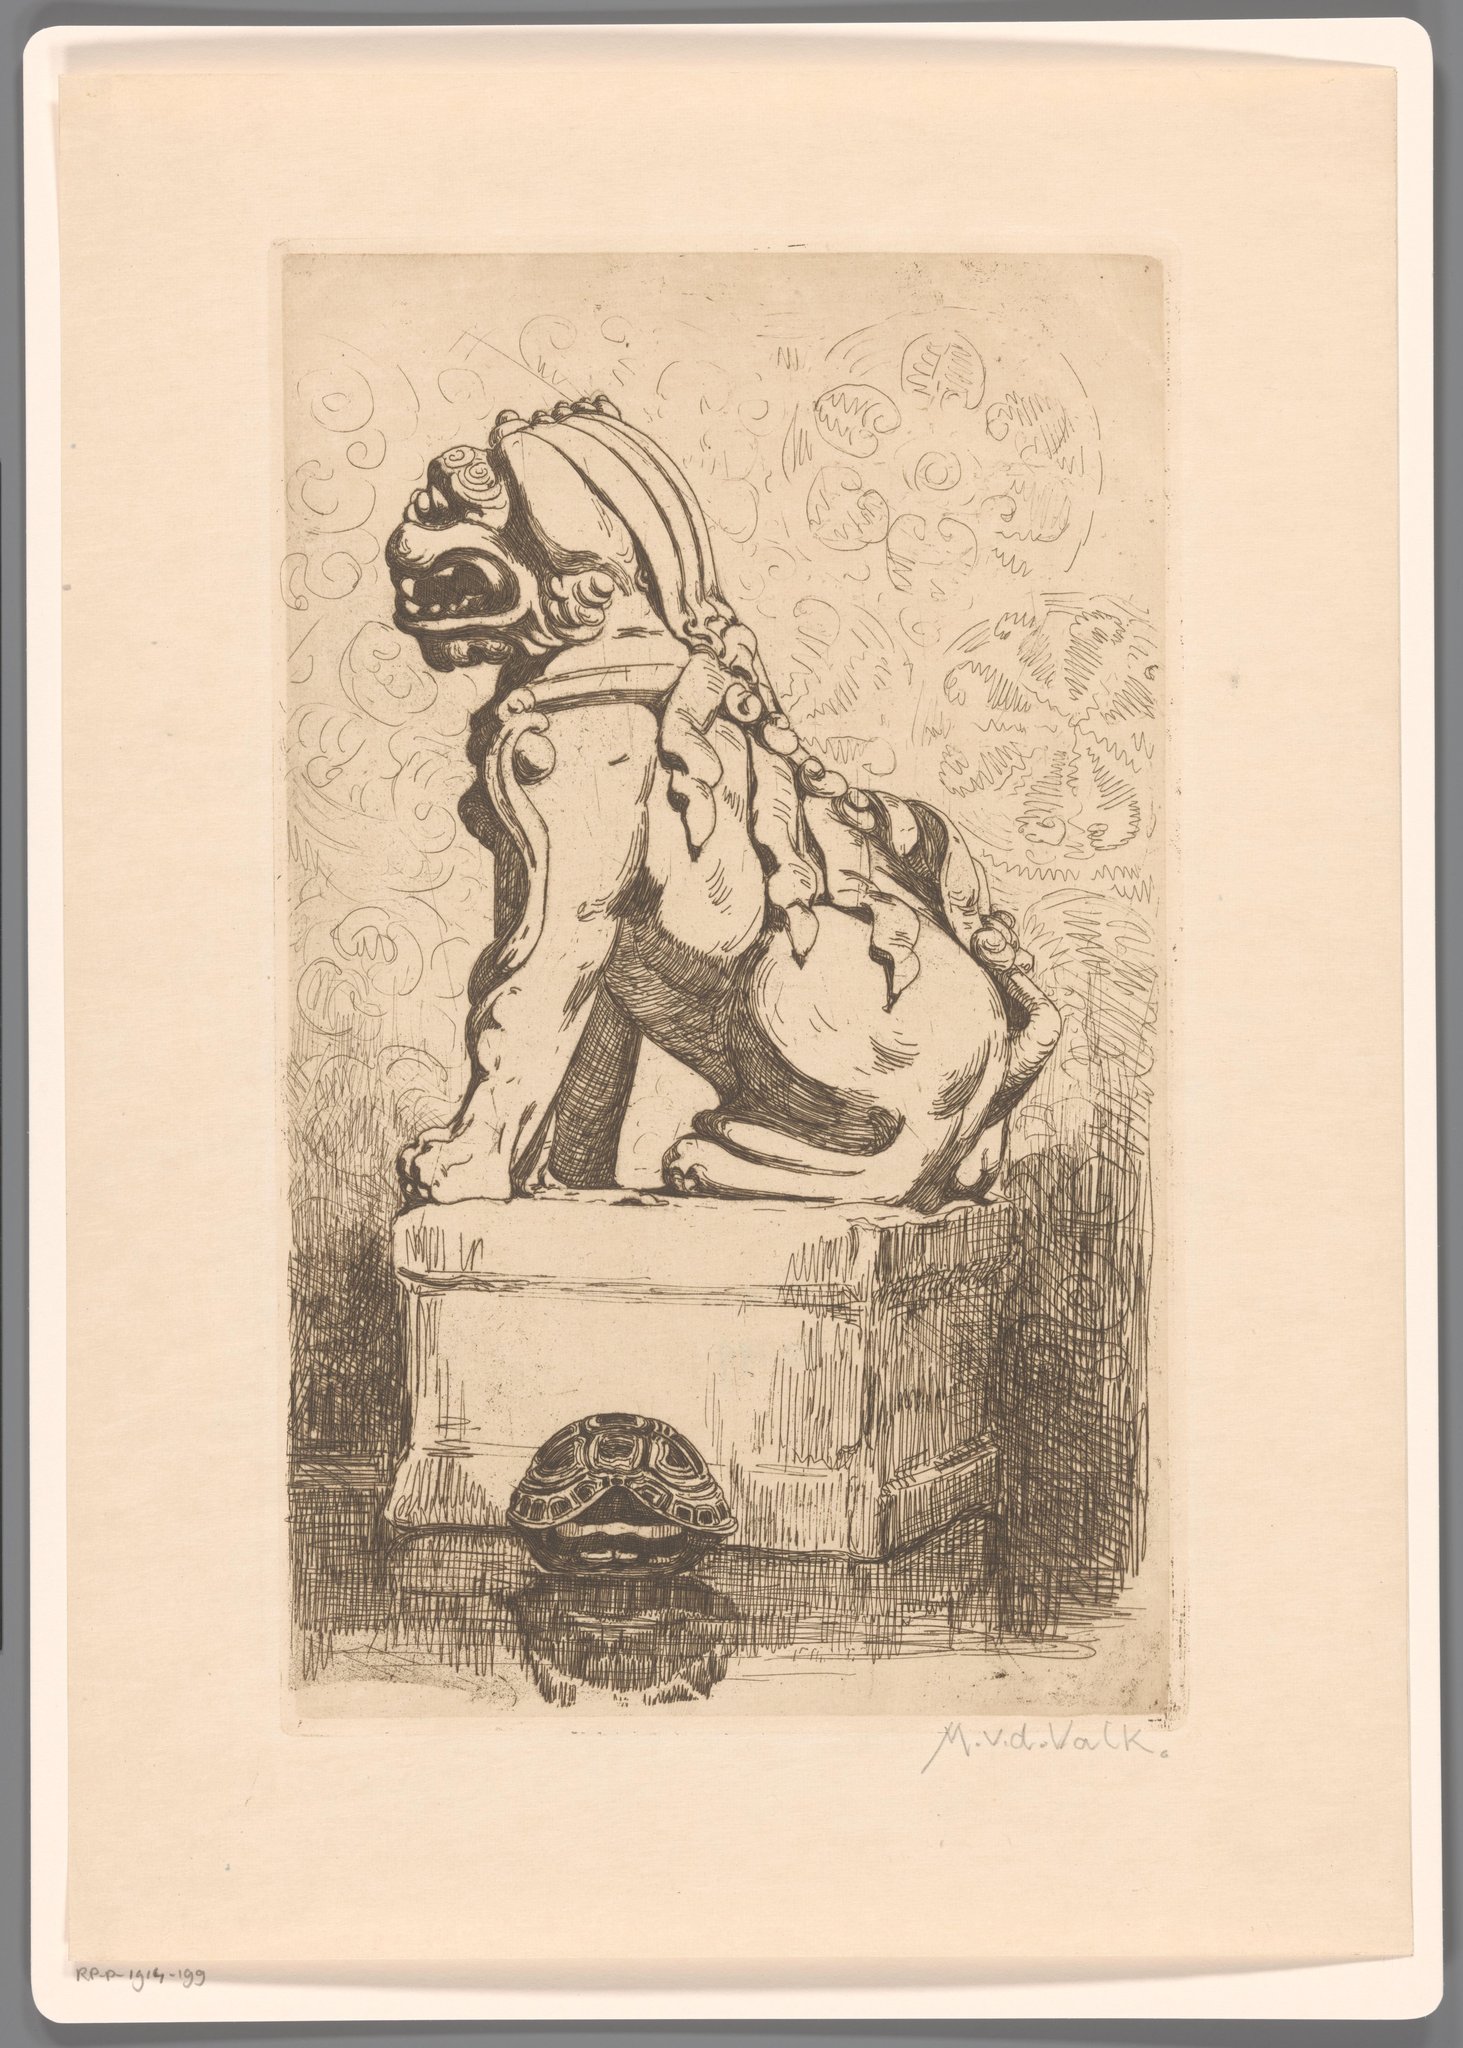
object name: print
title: Chinese tempelleeuw en schildpad schild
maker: maurits van der valk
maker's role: draughtsman, print maker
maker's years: 1857-1935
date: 1867-1914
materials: paper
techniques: etching, intaglio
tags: tortoises, turtles (+ shell, snail-shell etc.), monument, statue, beasts of prey, predatory animals: lion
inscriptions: collector's mark: Lugt 2233